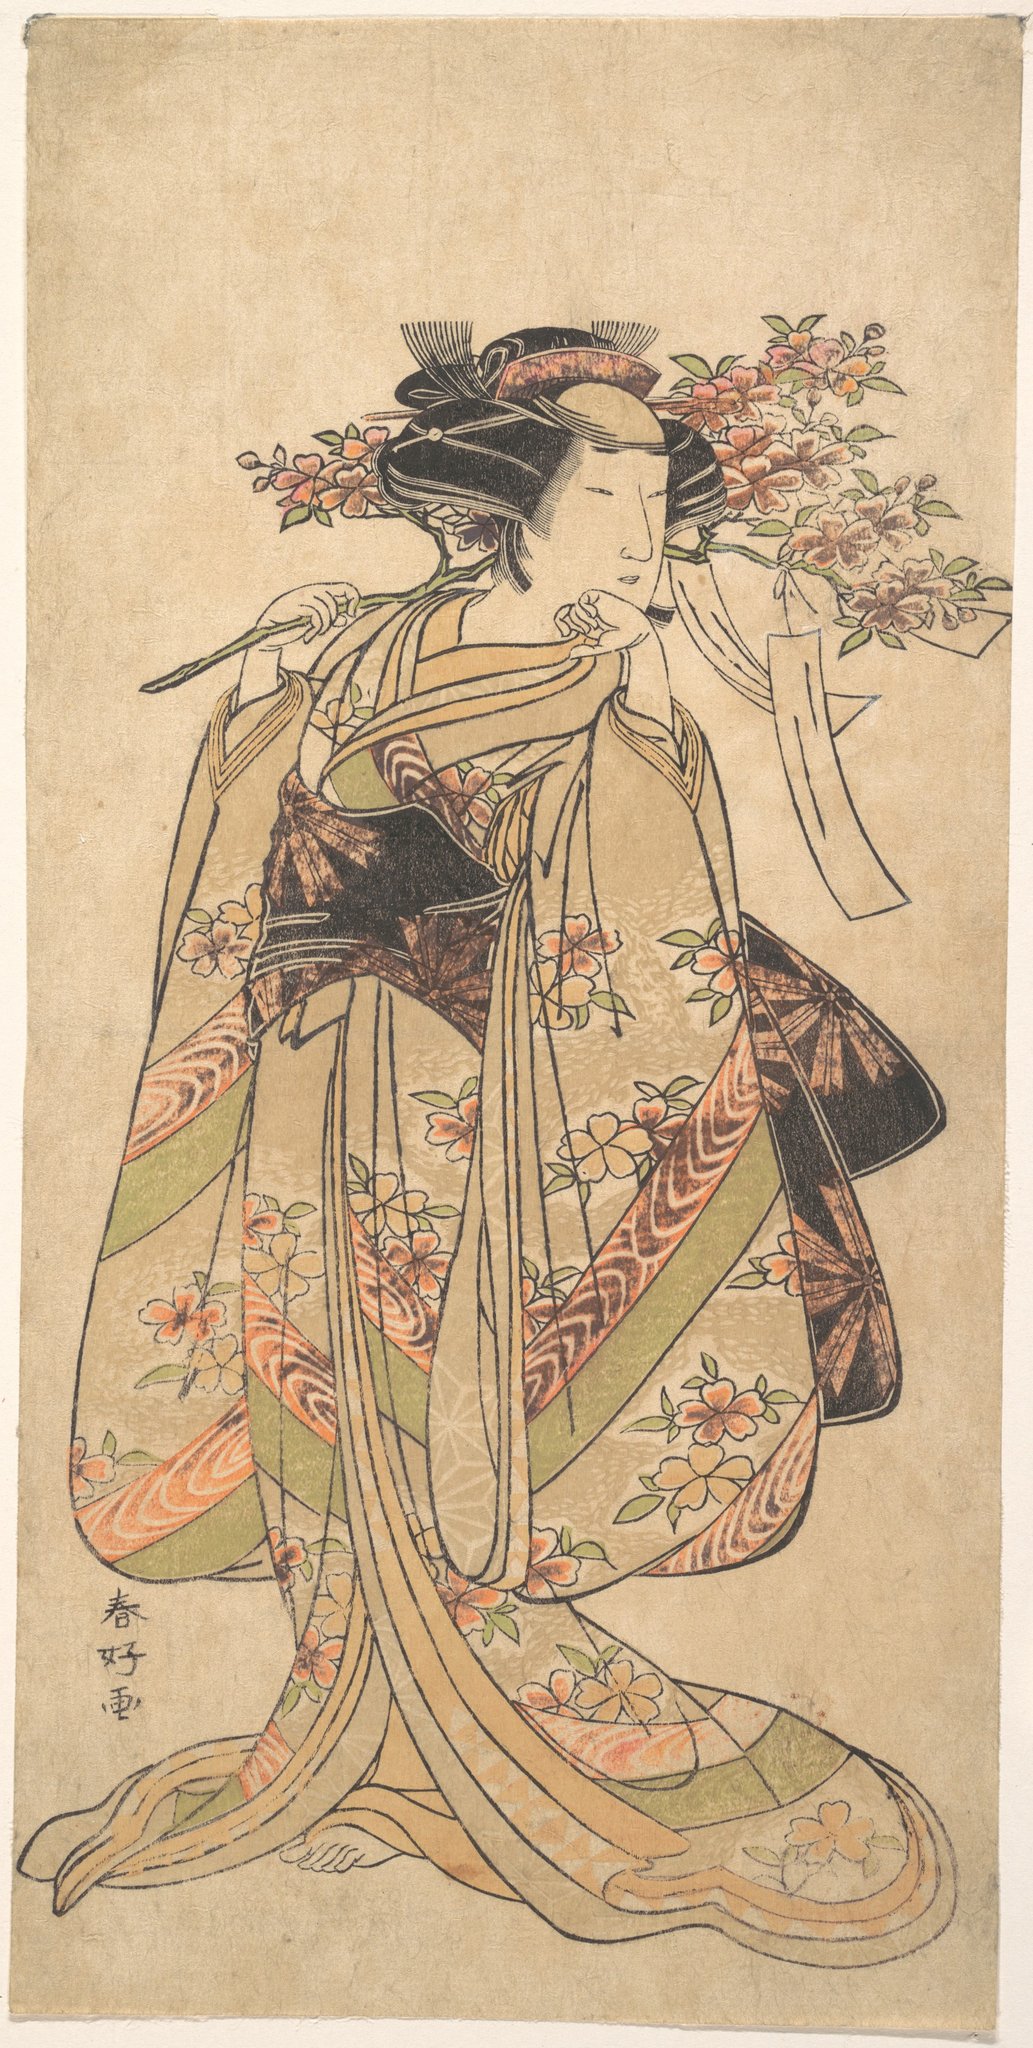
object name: print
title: The First Nakamura Tomijuro as a Woman Walking Toward the Left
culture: japanese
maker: katsukawa shunkō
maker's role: artist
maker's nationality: japanese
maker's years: 1743-1812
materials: ink, paper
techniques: woodblock print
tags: women